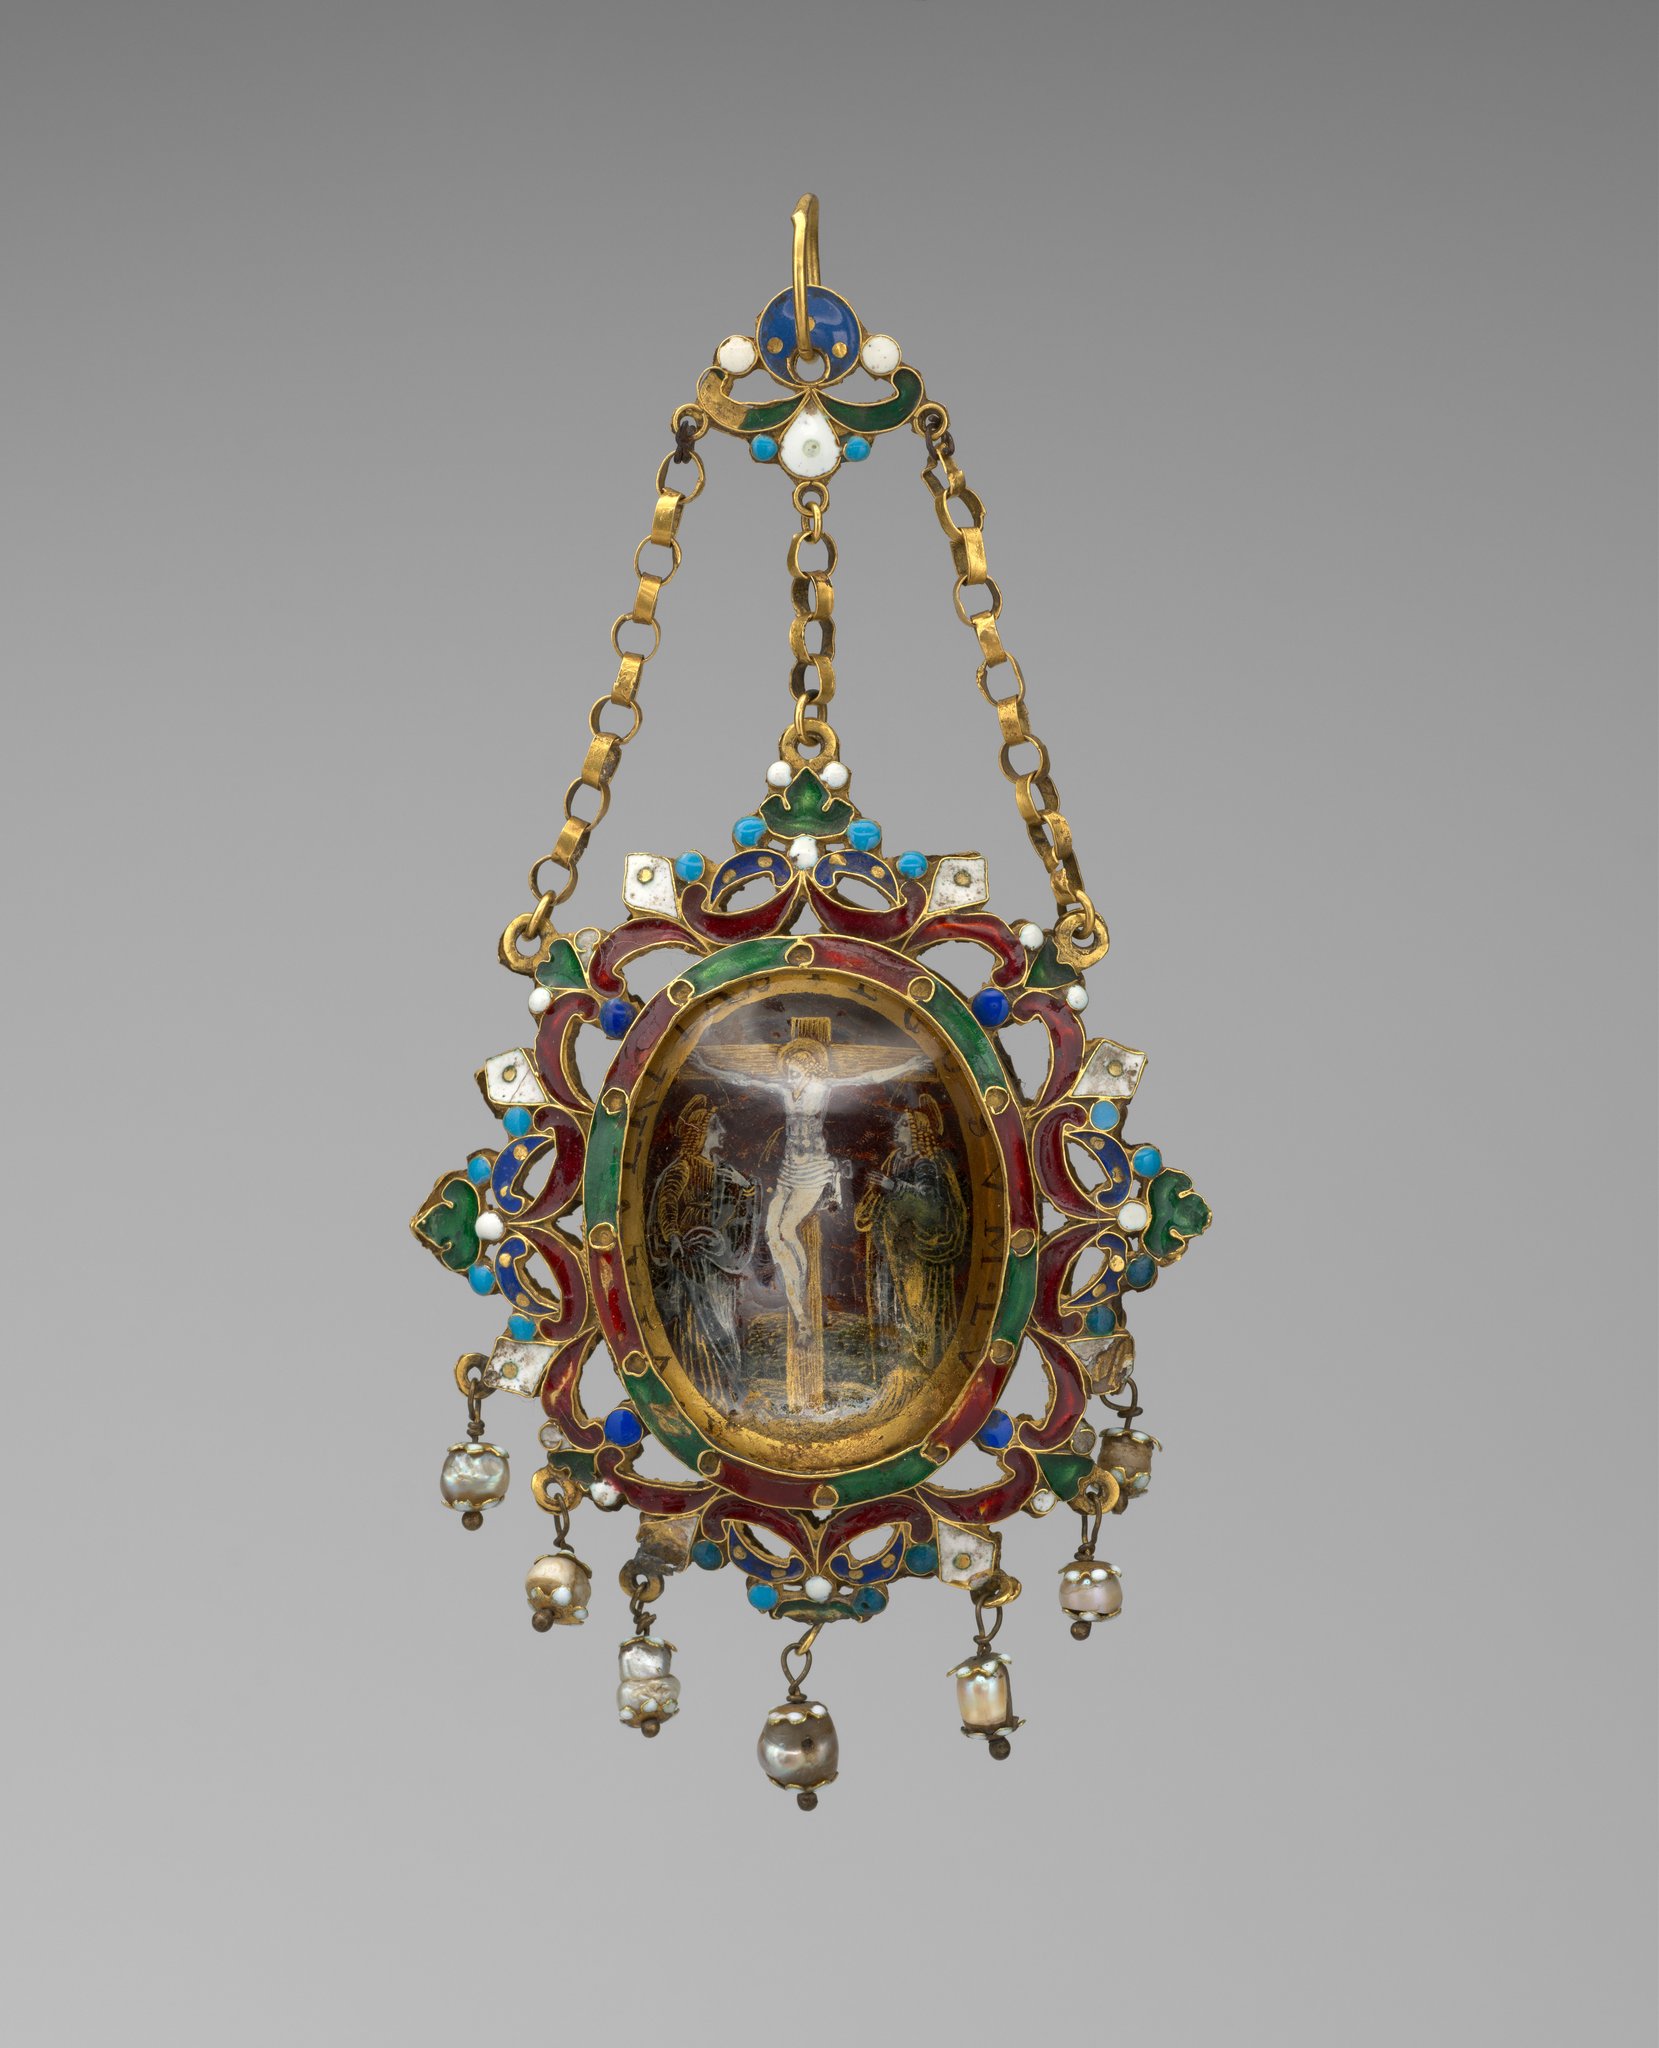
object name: pendant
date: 1601-1700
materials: enamel, gold, pearl